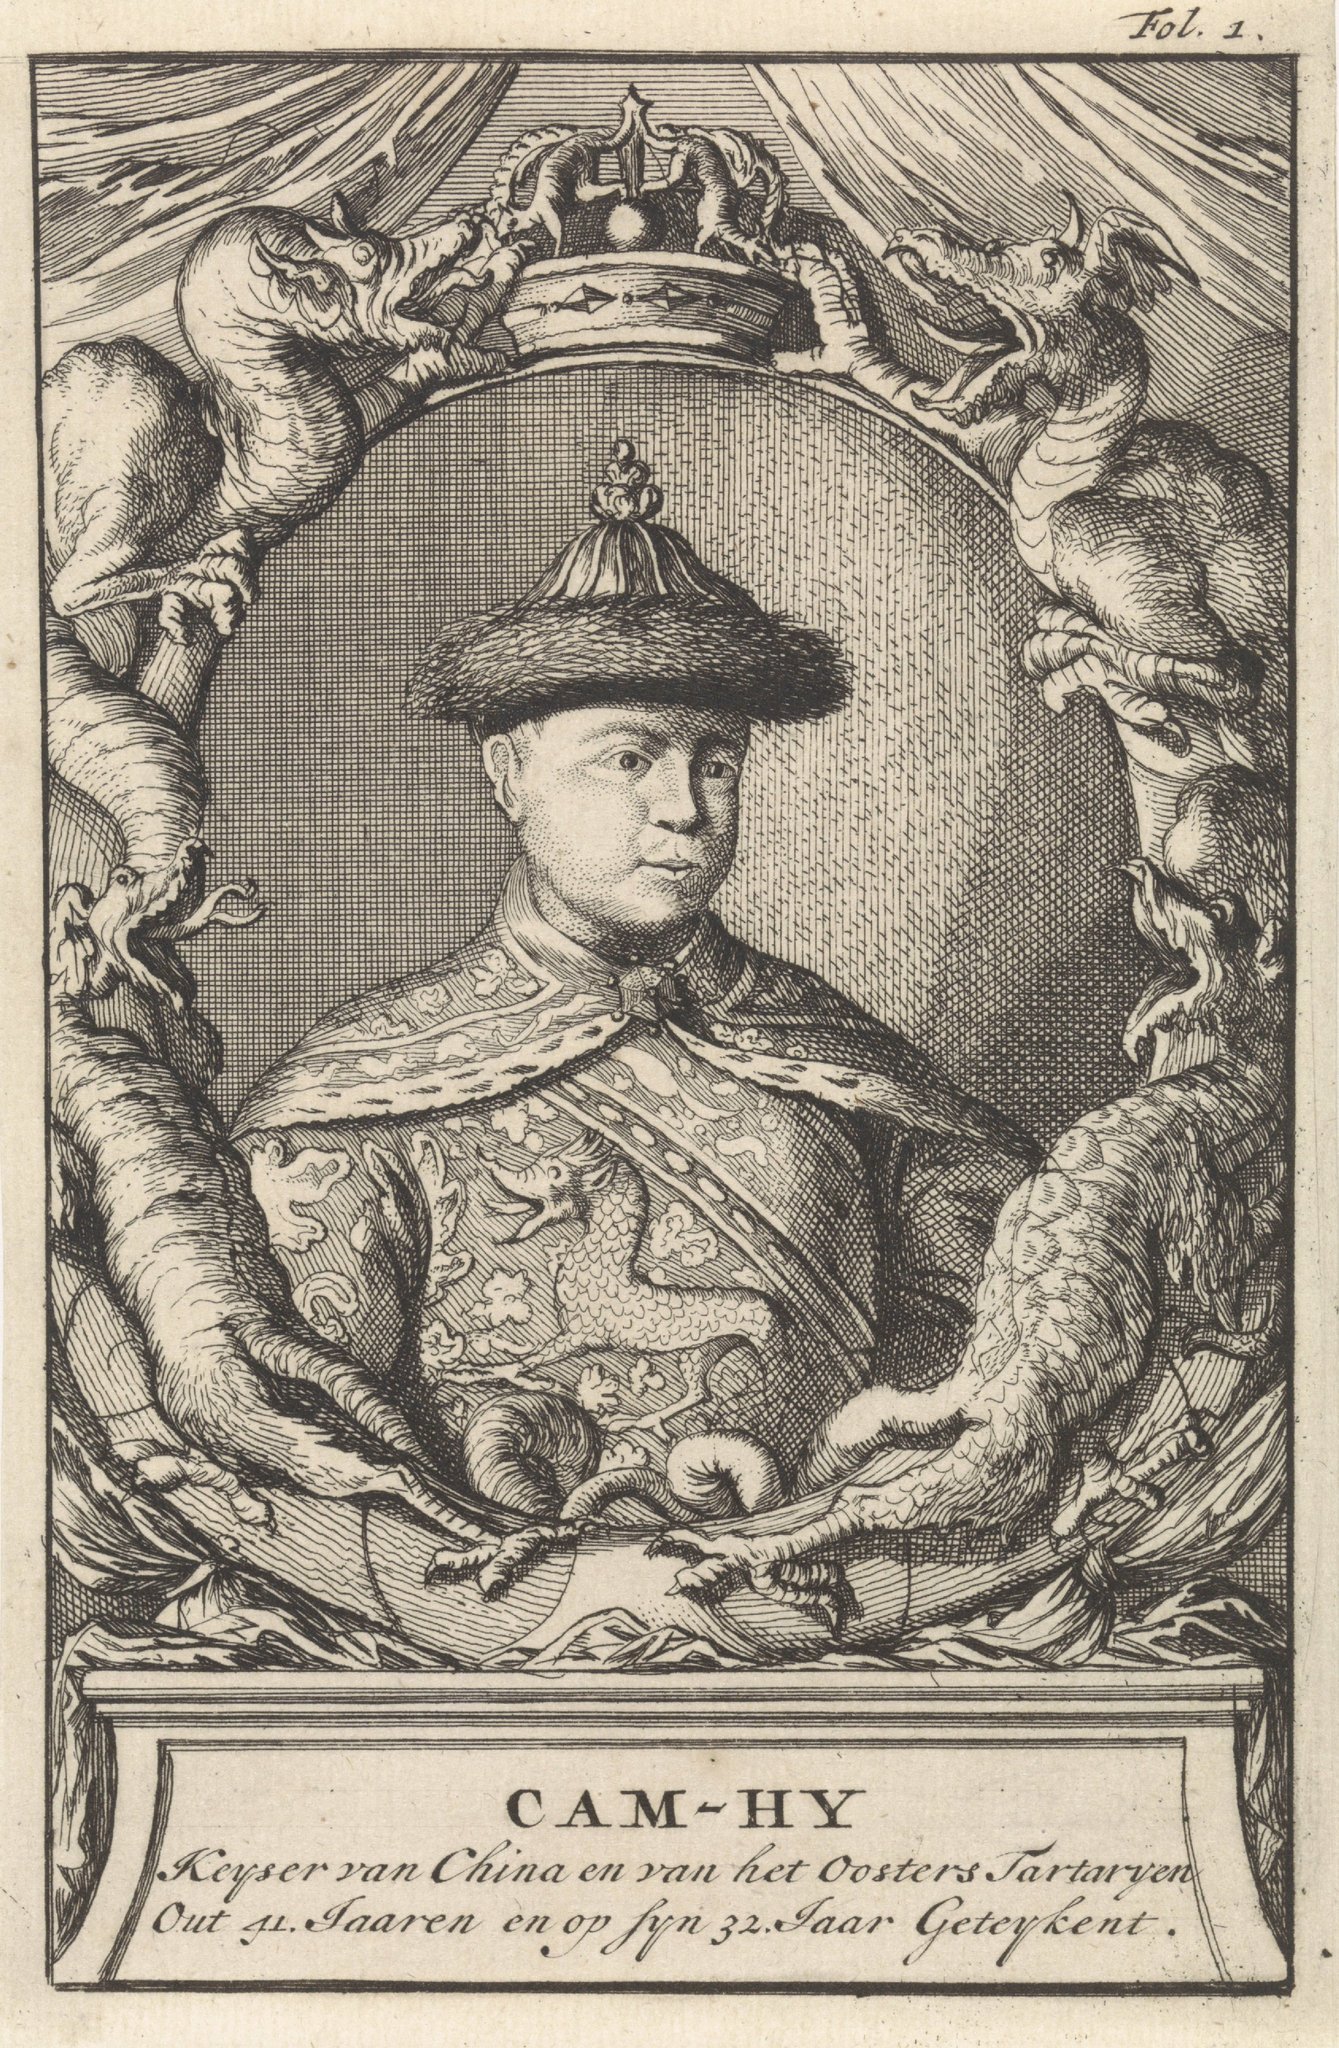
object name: print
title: Portret Kangxi, keizer van China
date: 1698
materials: paper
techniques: etching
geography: amsterdam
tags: keizer, kangxi (keizer van china)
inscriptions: collector's mark: Lugt 2228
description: Illustratie uit: Le Comte, Louis. Beschryvinge van het machtige keyserryk China, 2 delen. Den Haag: Engelbrecht Boucquet, 1698.